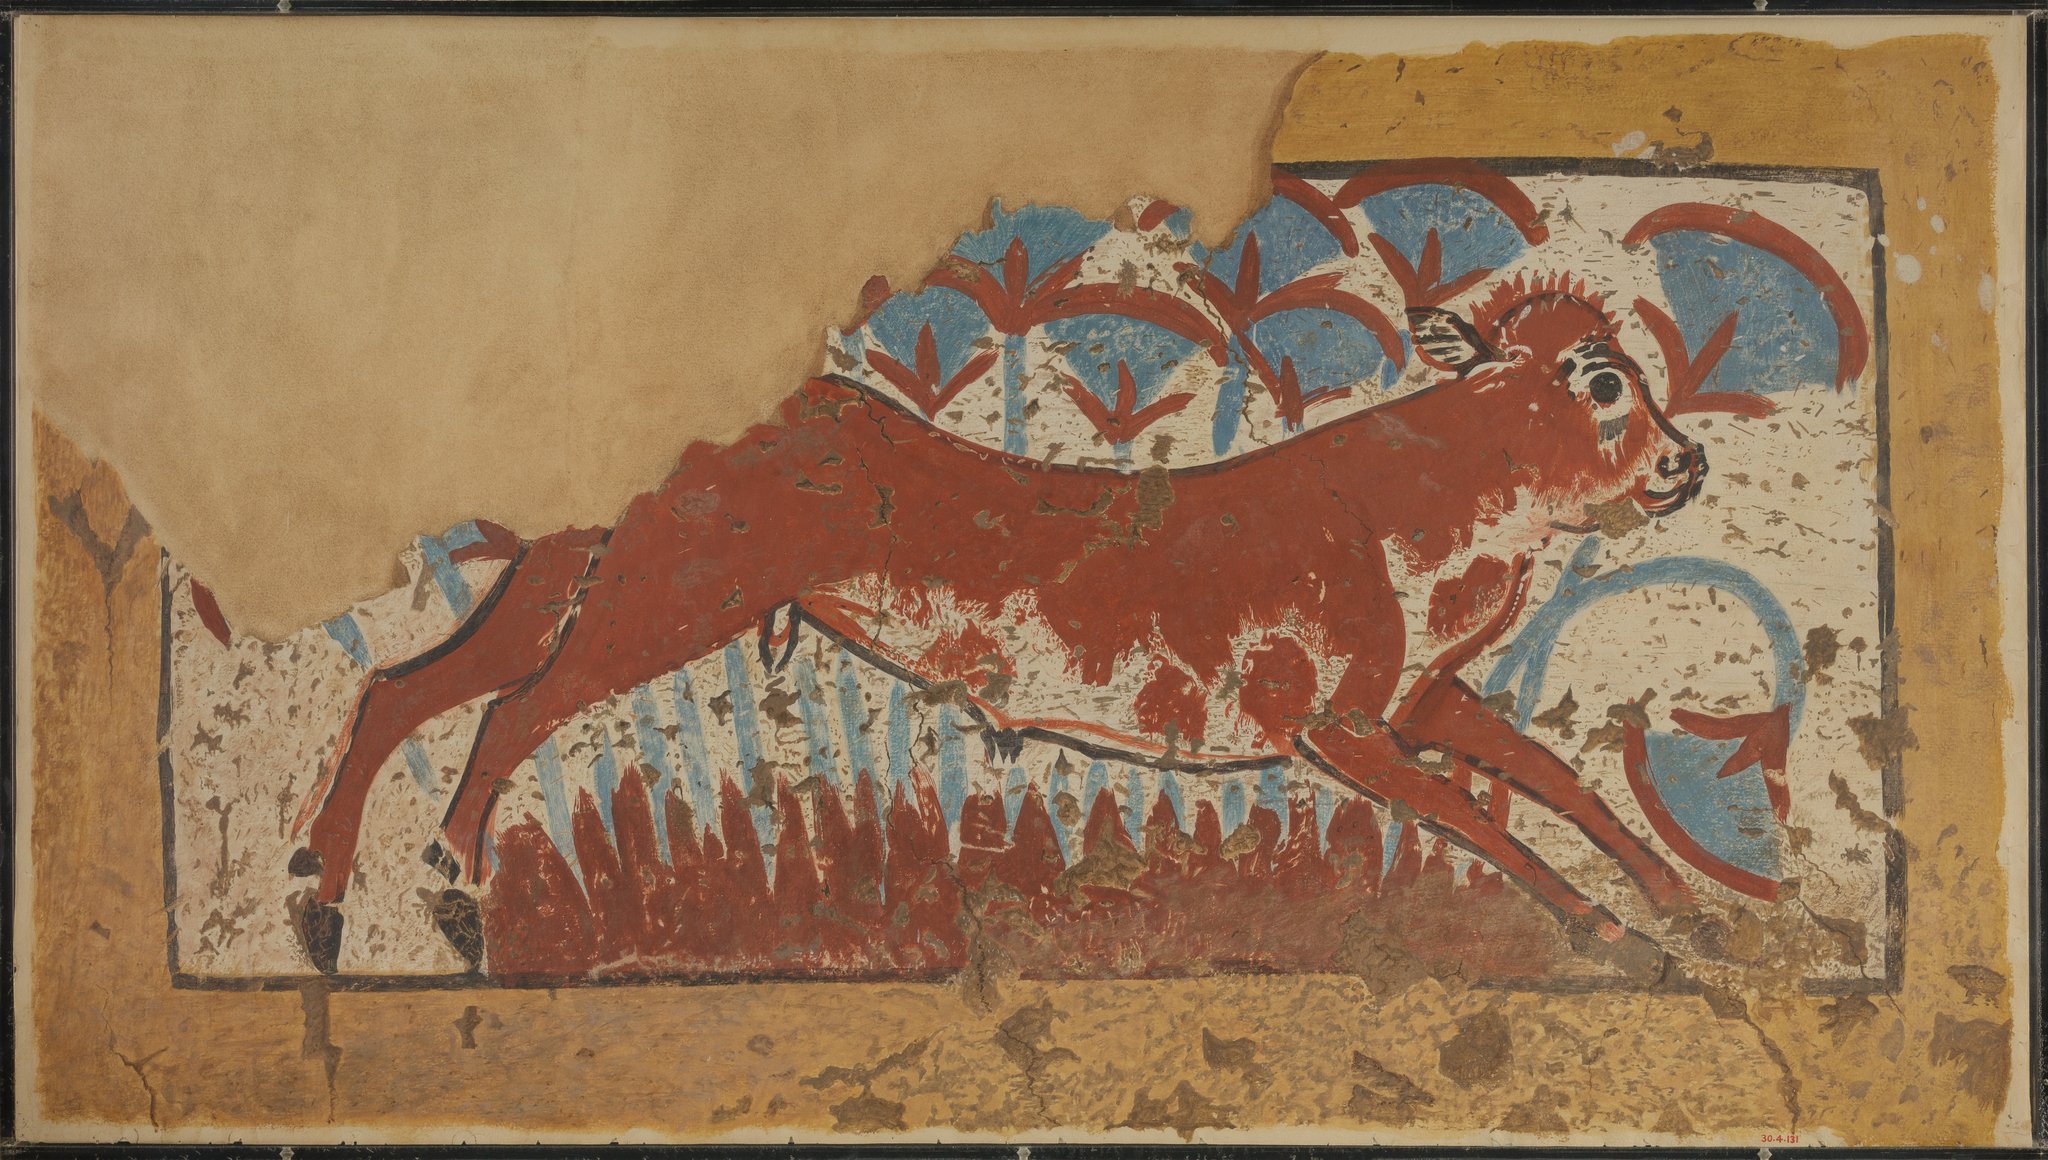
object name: facsimile, malqata, papyrus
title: Calf in a Papyrus Marsh, Palace of Amenhotep III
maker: norman de garis davies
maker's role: artist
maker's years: 1865-1941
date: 1390-1352 BCE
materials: paper, paint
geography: egypt